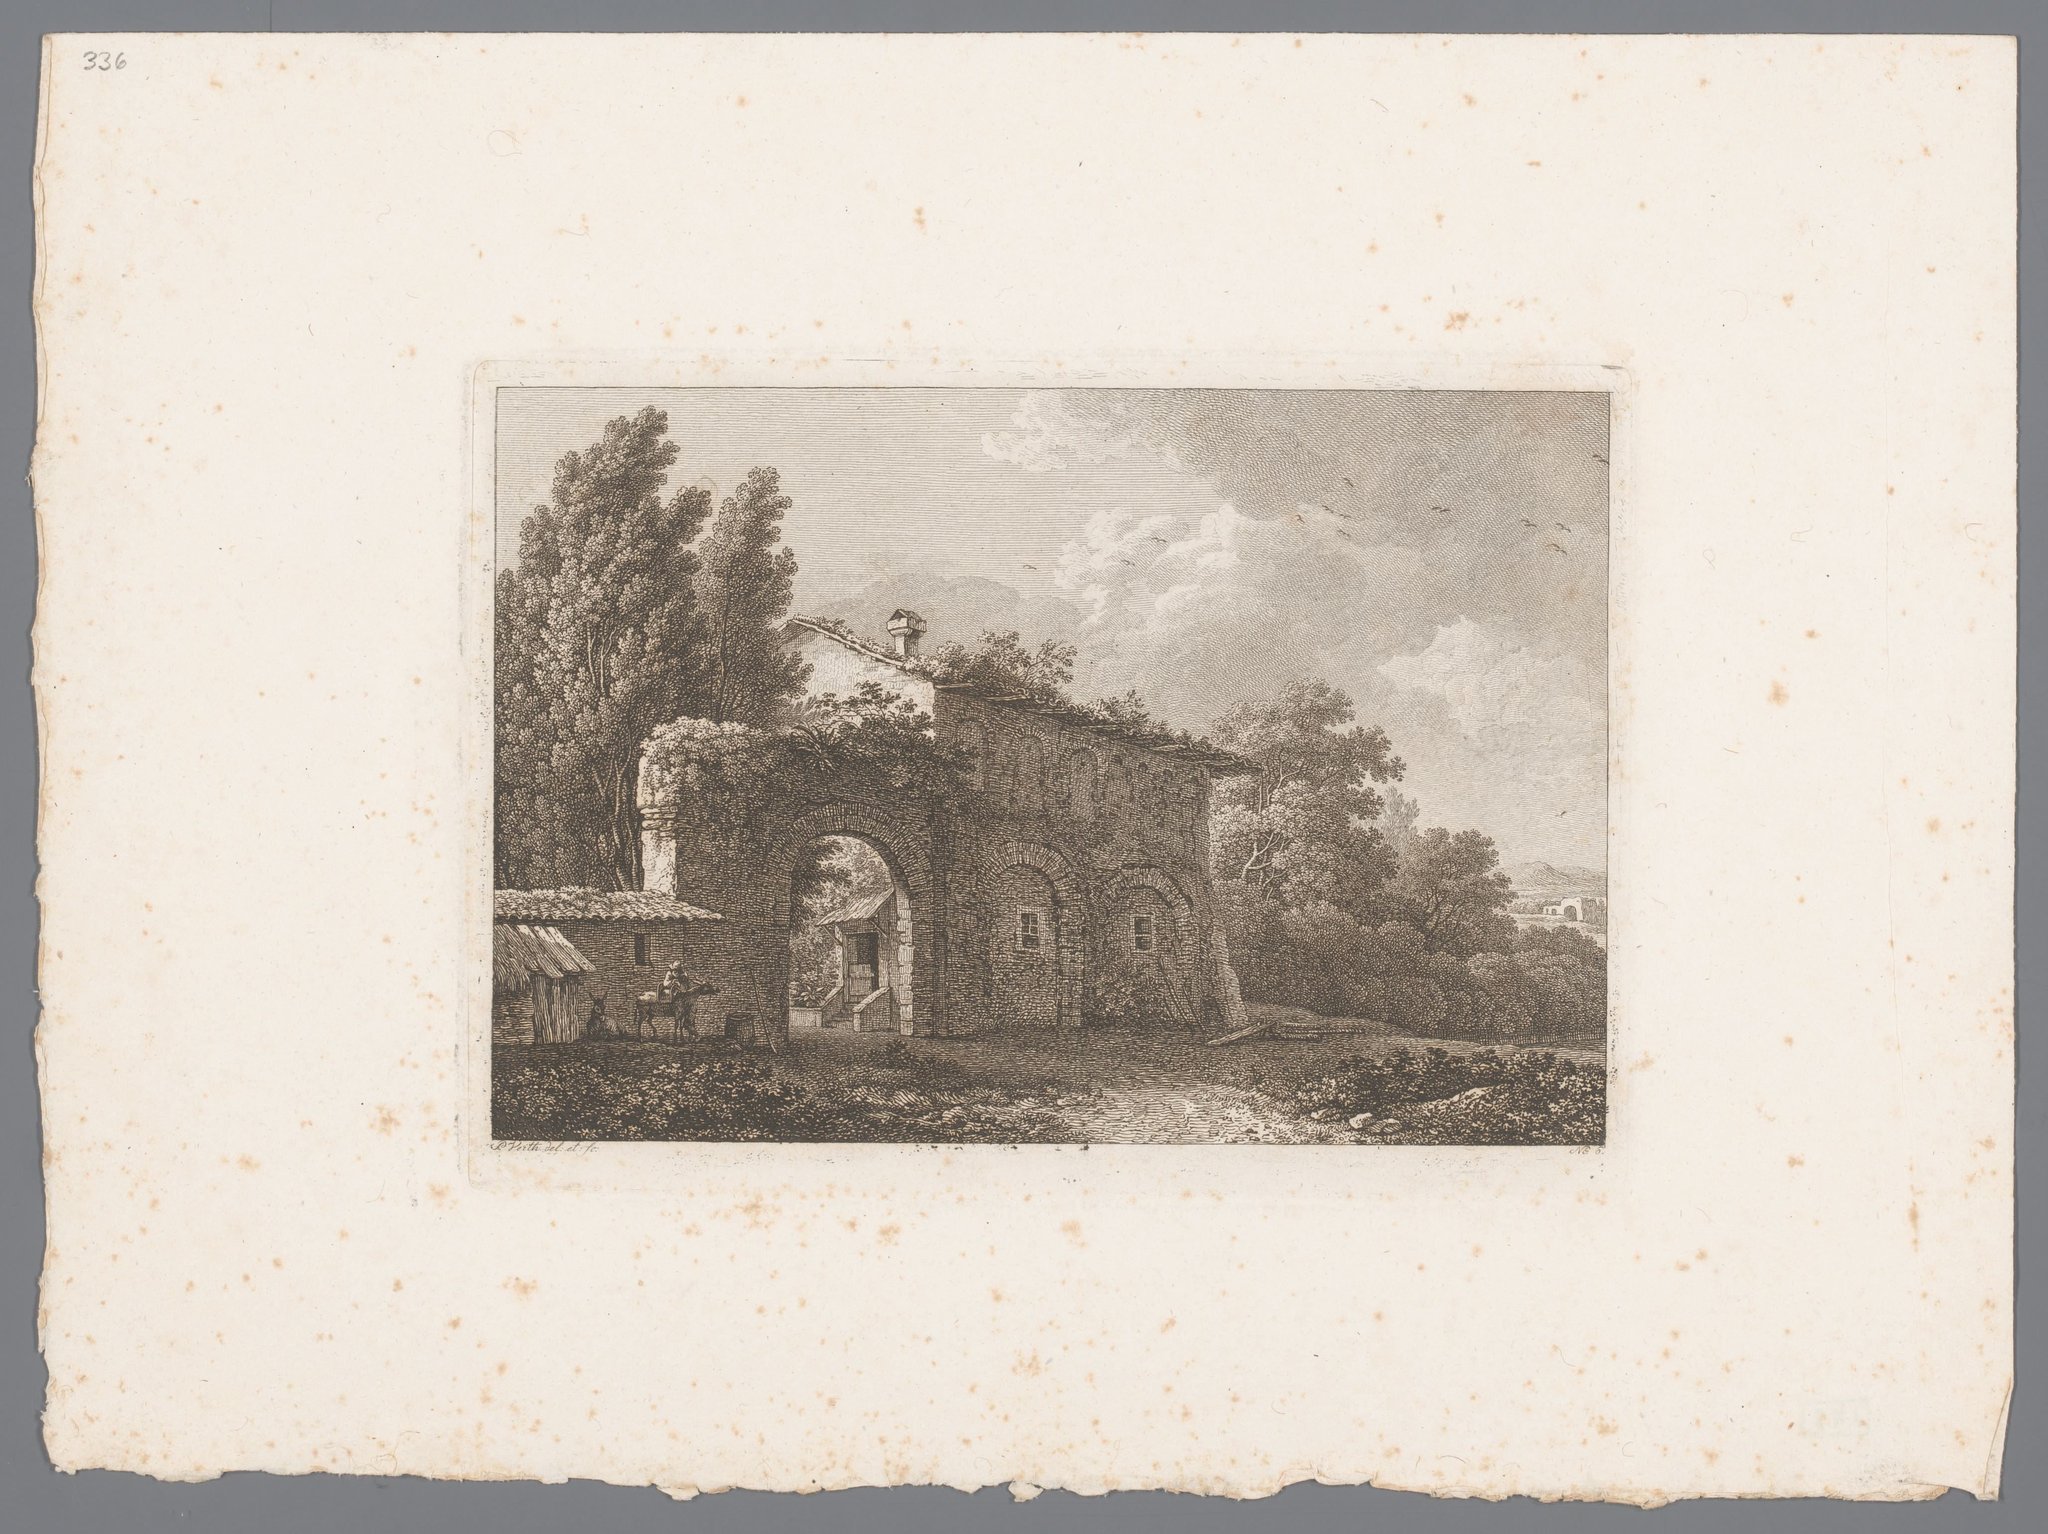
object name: print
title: Italienischises Winzerhaus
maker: philipp veith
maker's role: draughtsman, print maker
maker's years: 1768-1837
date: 1824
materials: paper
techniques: etching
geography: dresden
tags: city-view, and landscape with man-made constructions, ass, donkey, (traveller) resting in the open air, italy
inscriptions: number: ‘223003/0295’, collector's mark: Lugt 2760, collector's mark: Lugt 2228, number: ‘336’, collector's mark: Lugt 3976